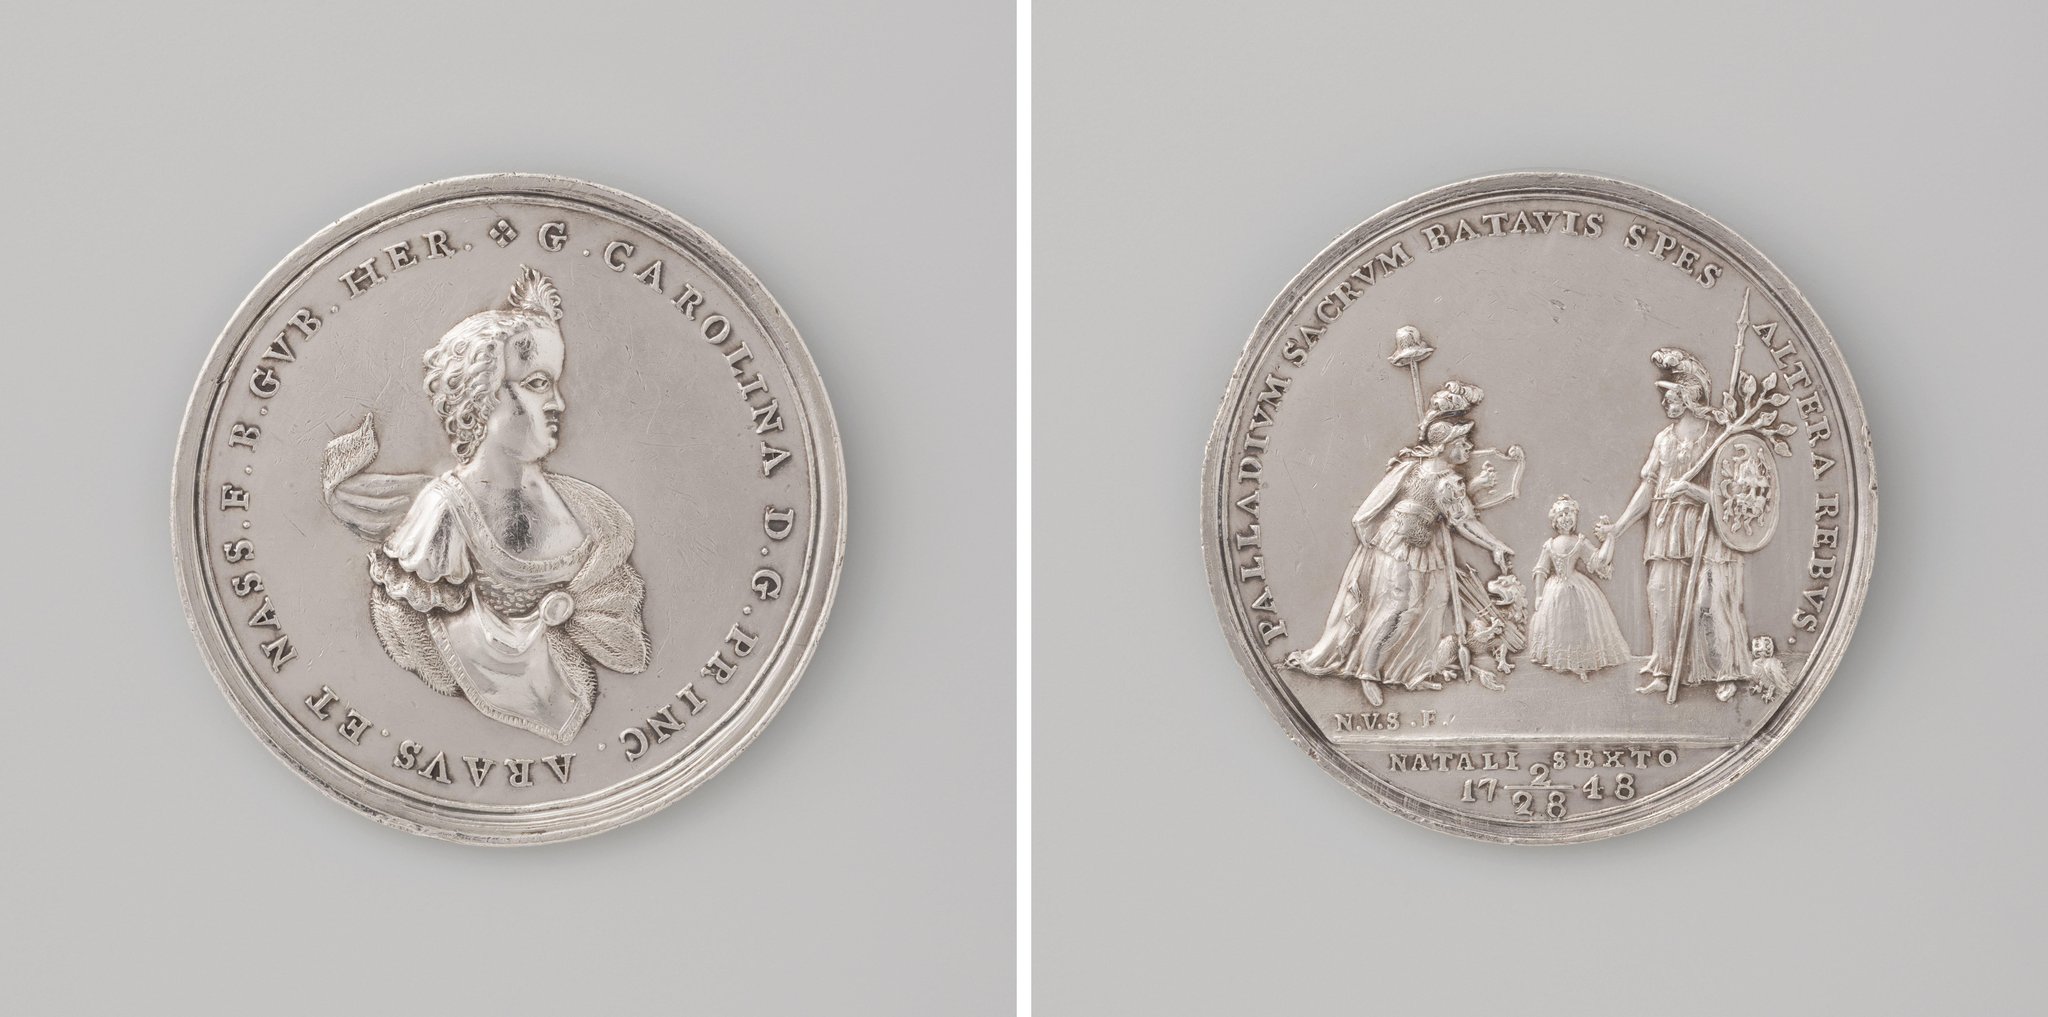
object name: history medal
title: Vijfde verjaardag van prinses Carolina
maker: nicolaas van swinderen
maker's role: jeweler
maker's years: 1705-1760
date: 1748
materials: silver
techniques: striking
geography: the hague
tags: carolina (prinses van oranje-nassau)